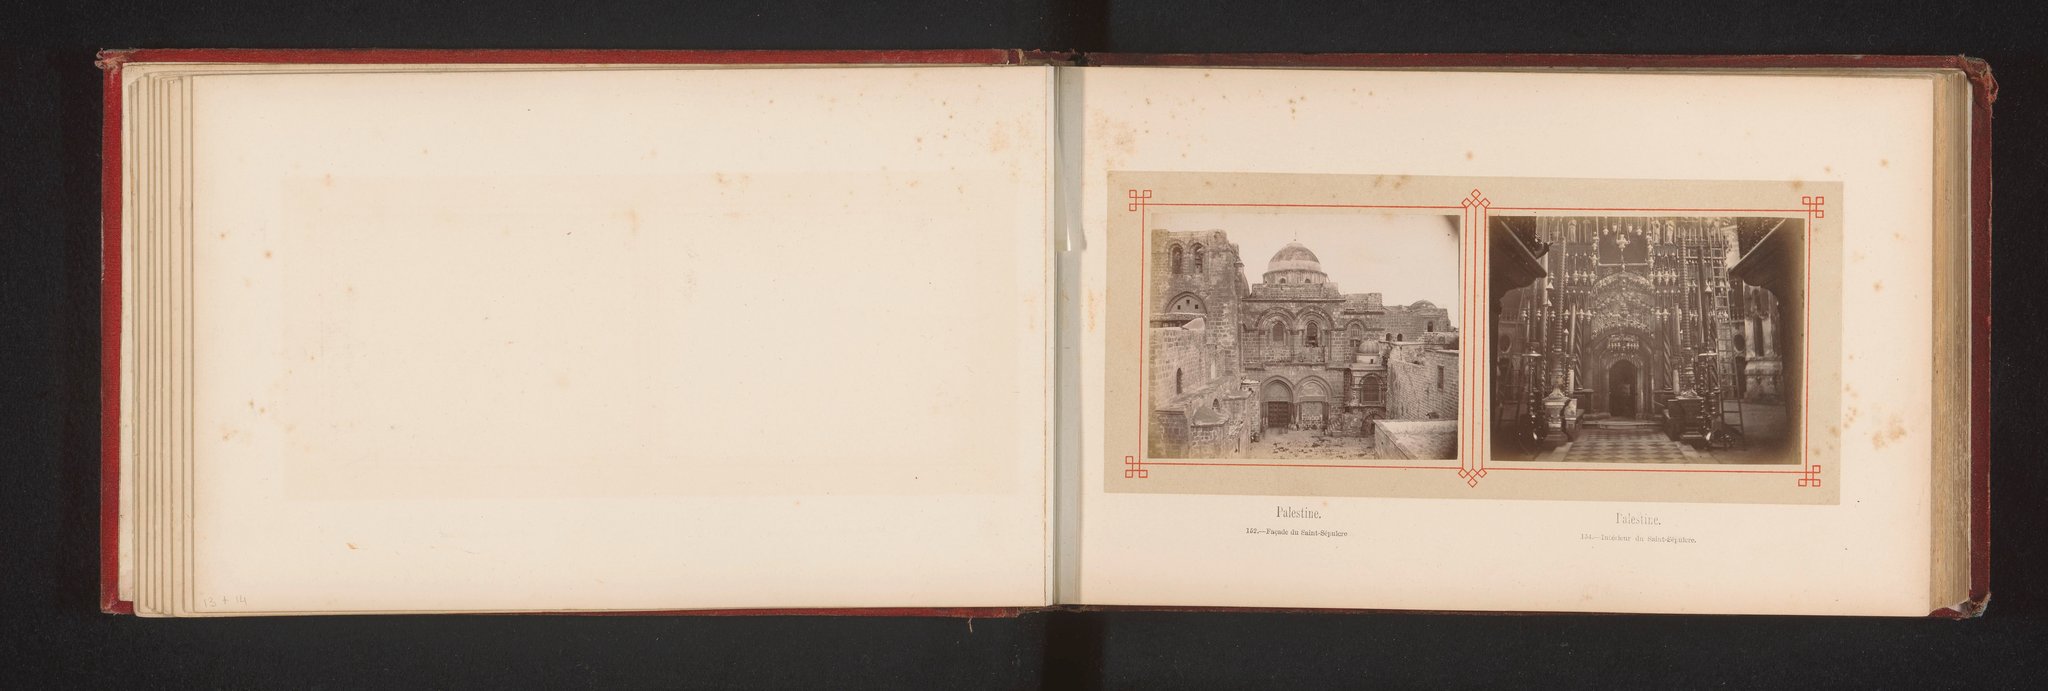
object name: page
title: Gezicht op de Heilig Grafkerk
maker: félix bonfils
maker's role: fotograaf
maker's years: 1831-1885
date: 1873-1878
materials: photographic support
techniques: albumen print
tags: church (exterior)